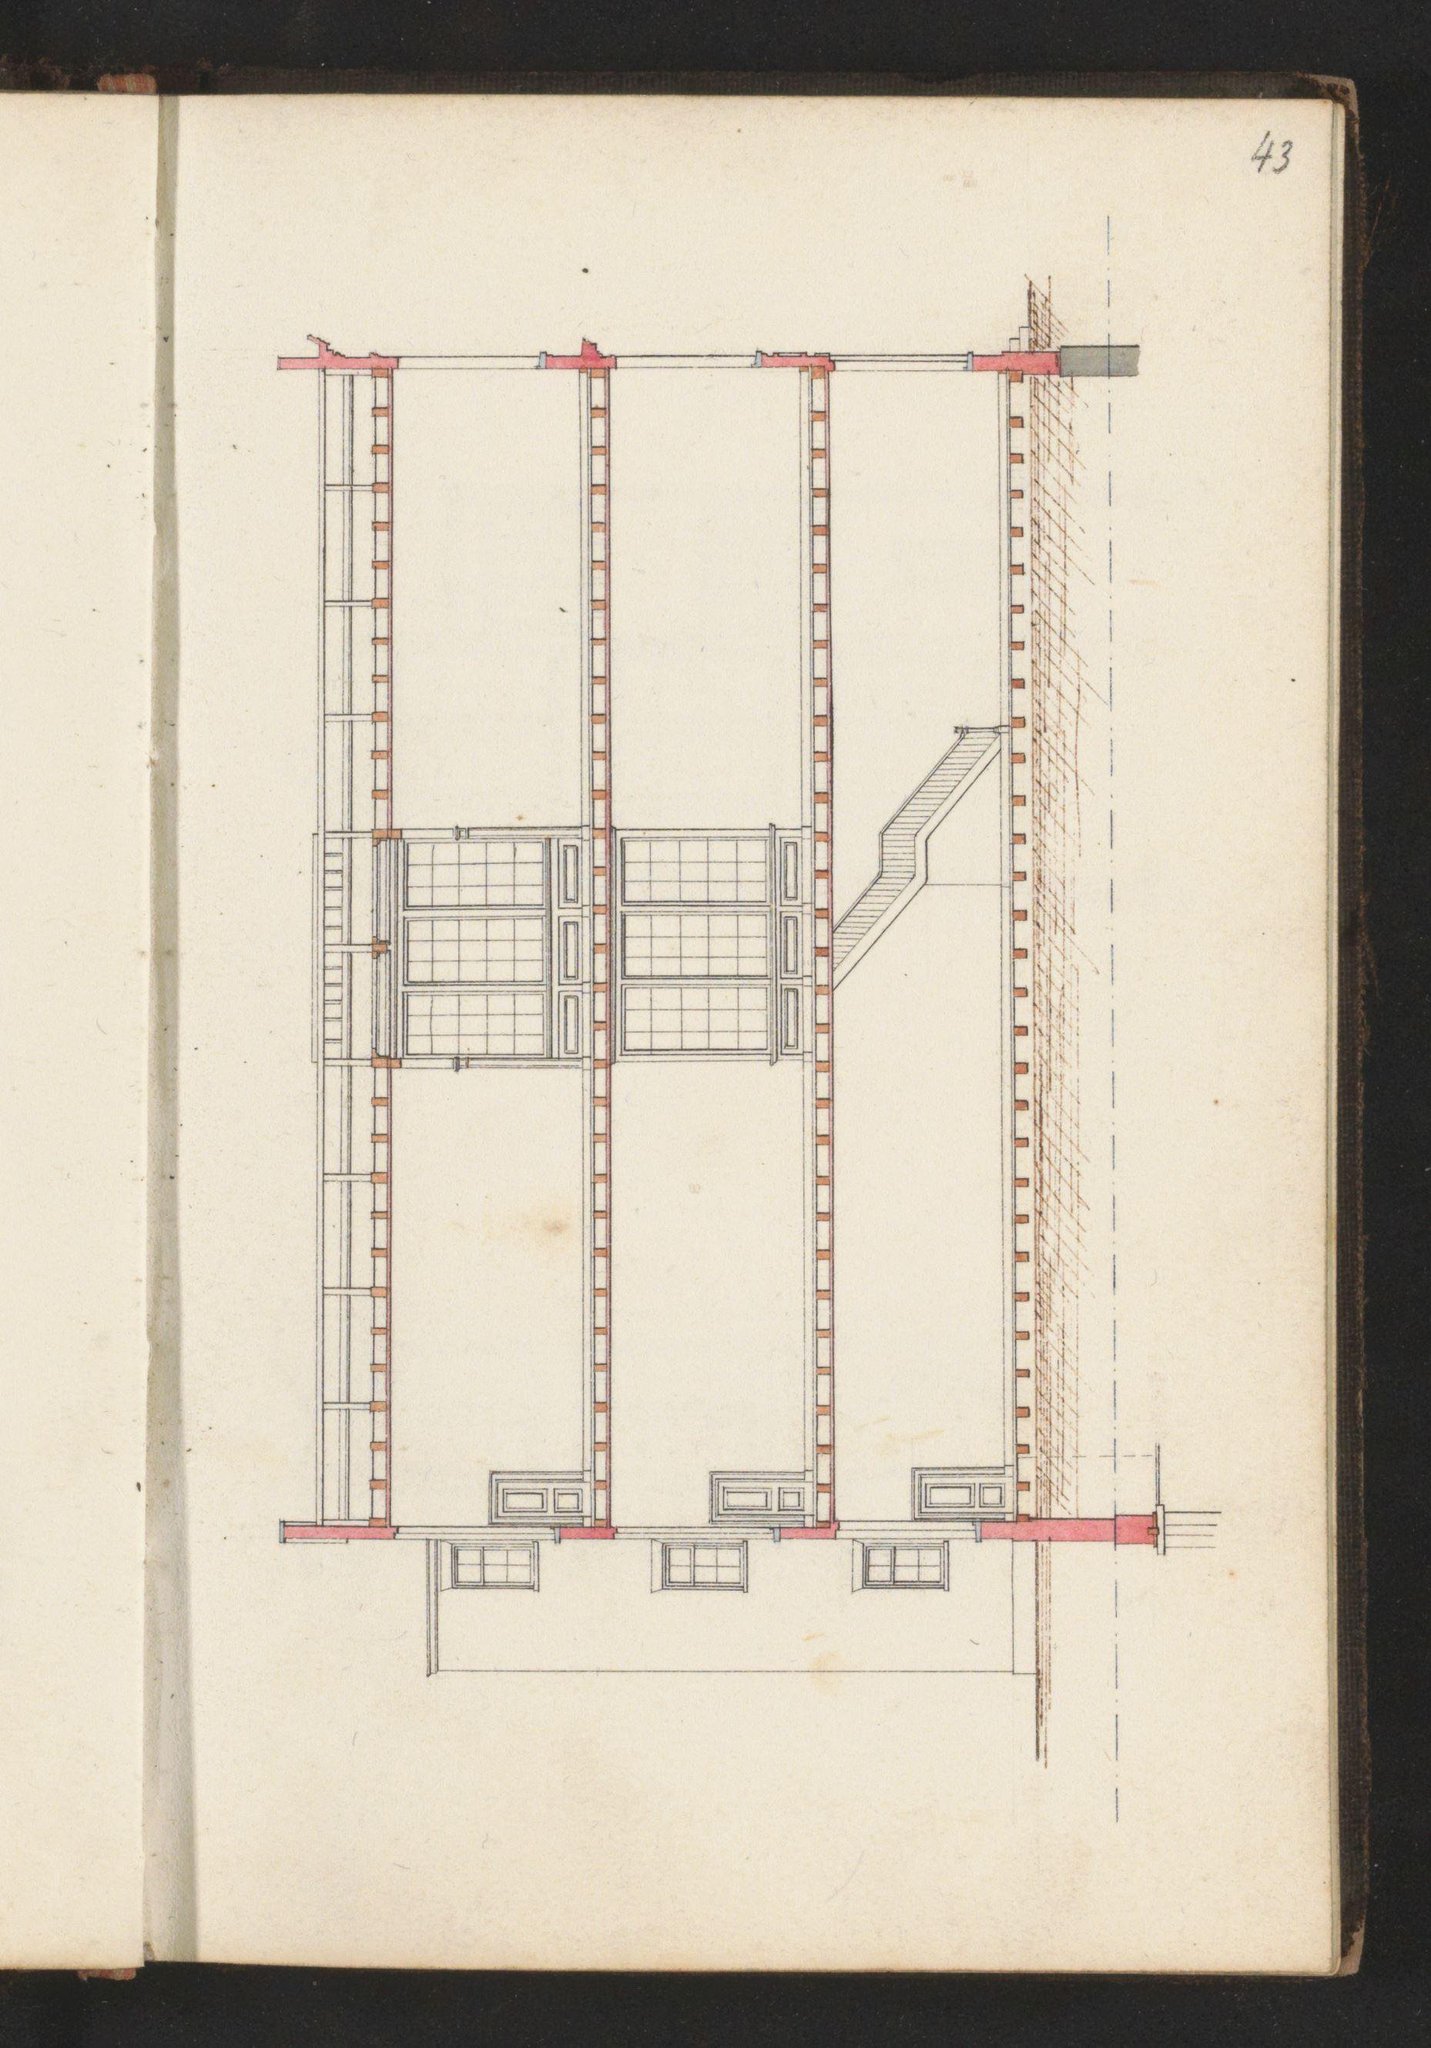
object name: sketchbook leaf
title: Doorsnede van een gebouw over de lengte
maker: willem springer jr.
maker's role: draughtsman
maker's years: 1815-1907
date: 1864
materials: ink, paper, watercolor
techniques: brush, pen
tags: section ~ architectural design or model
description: Pagina 43 uit een schetsboek met 164 pagina's.